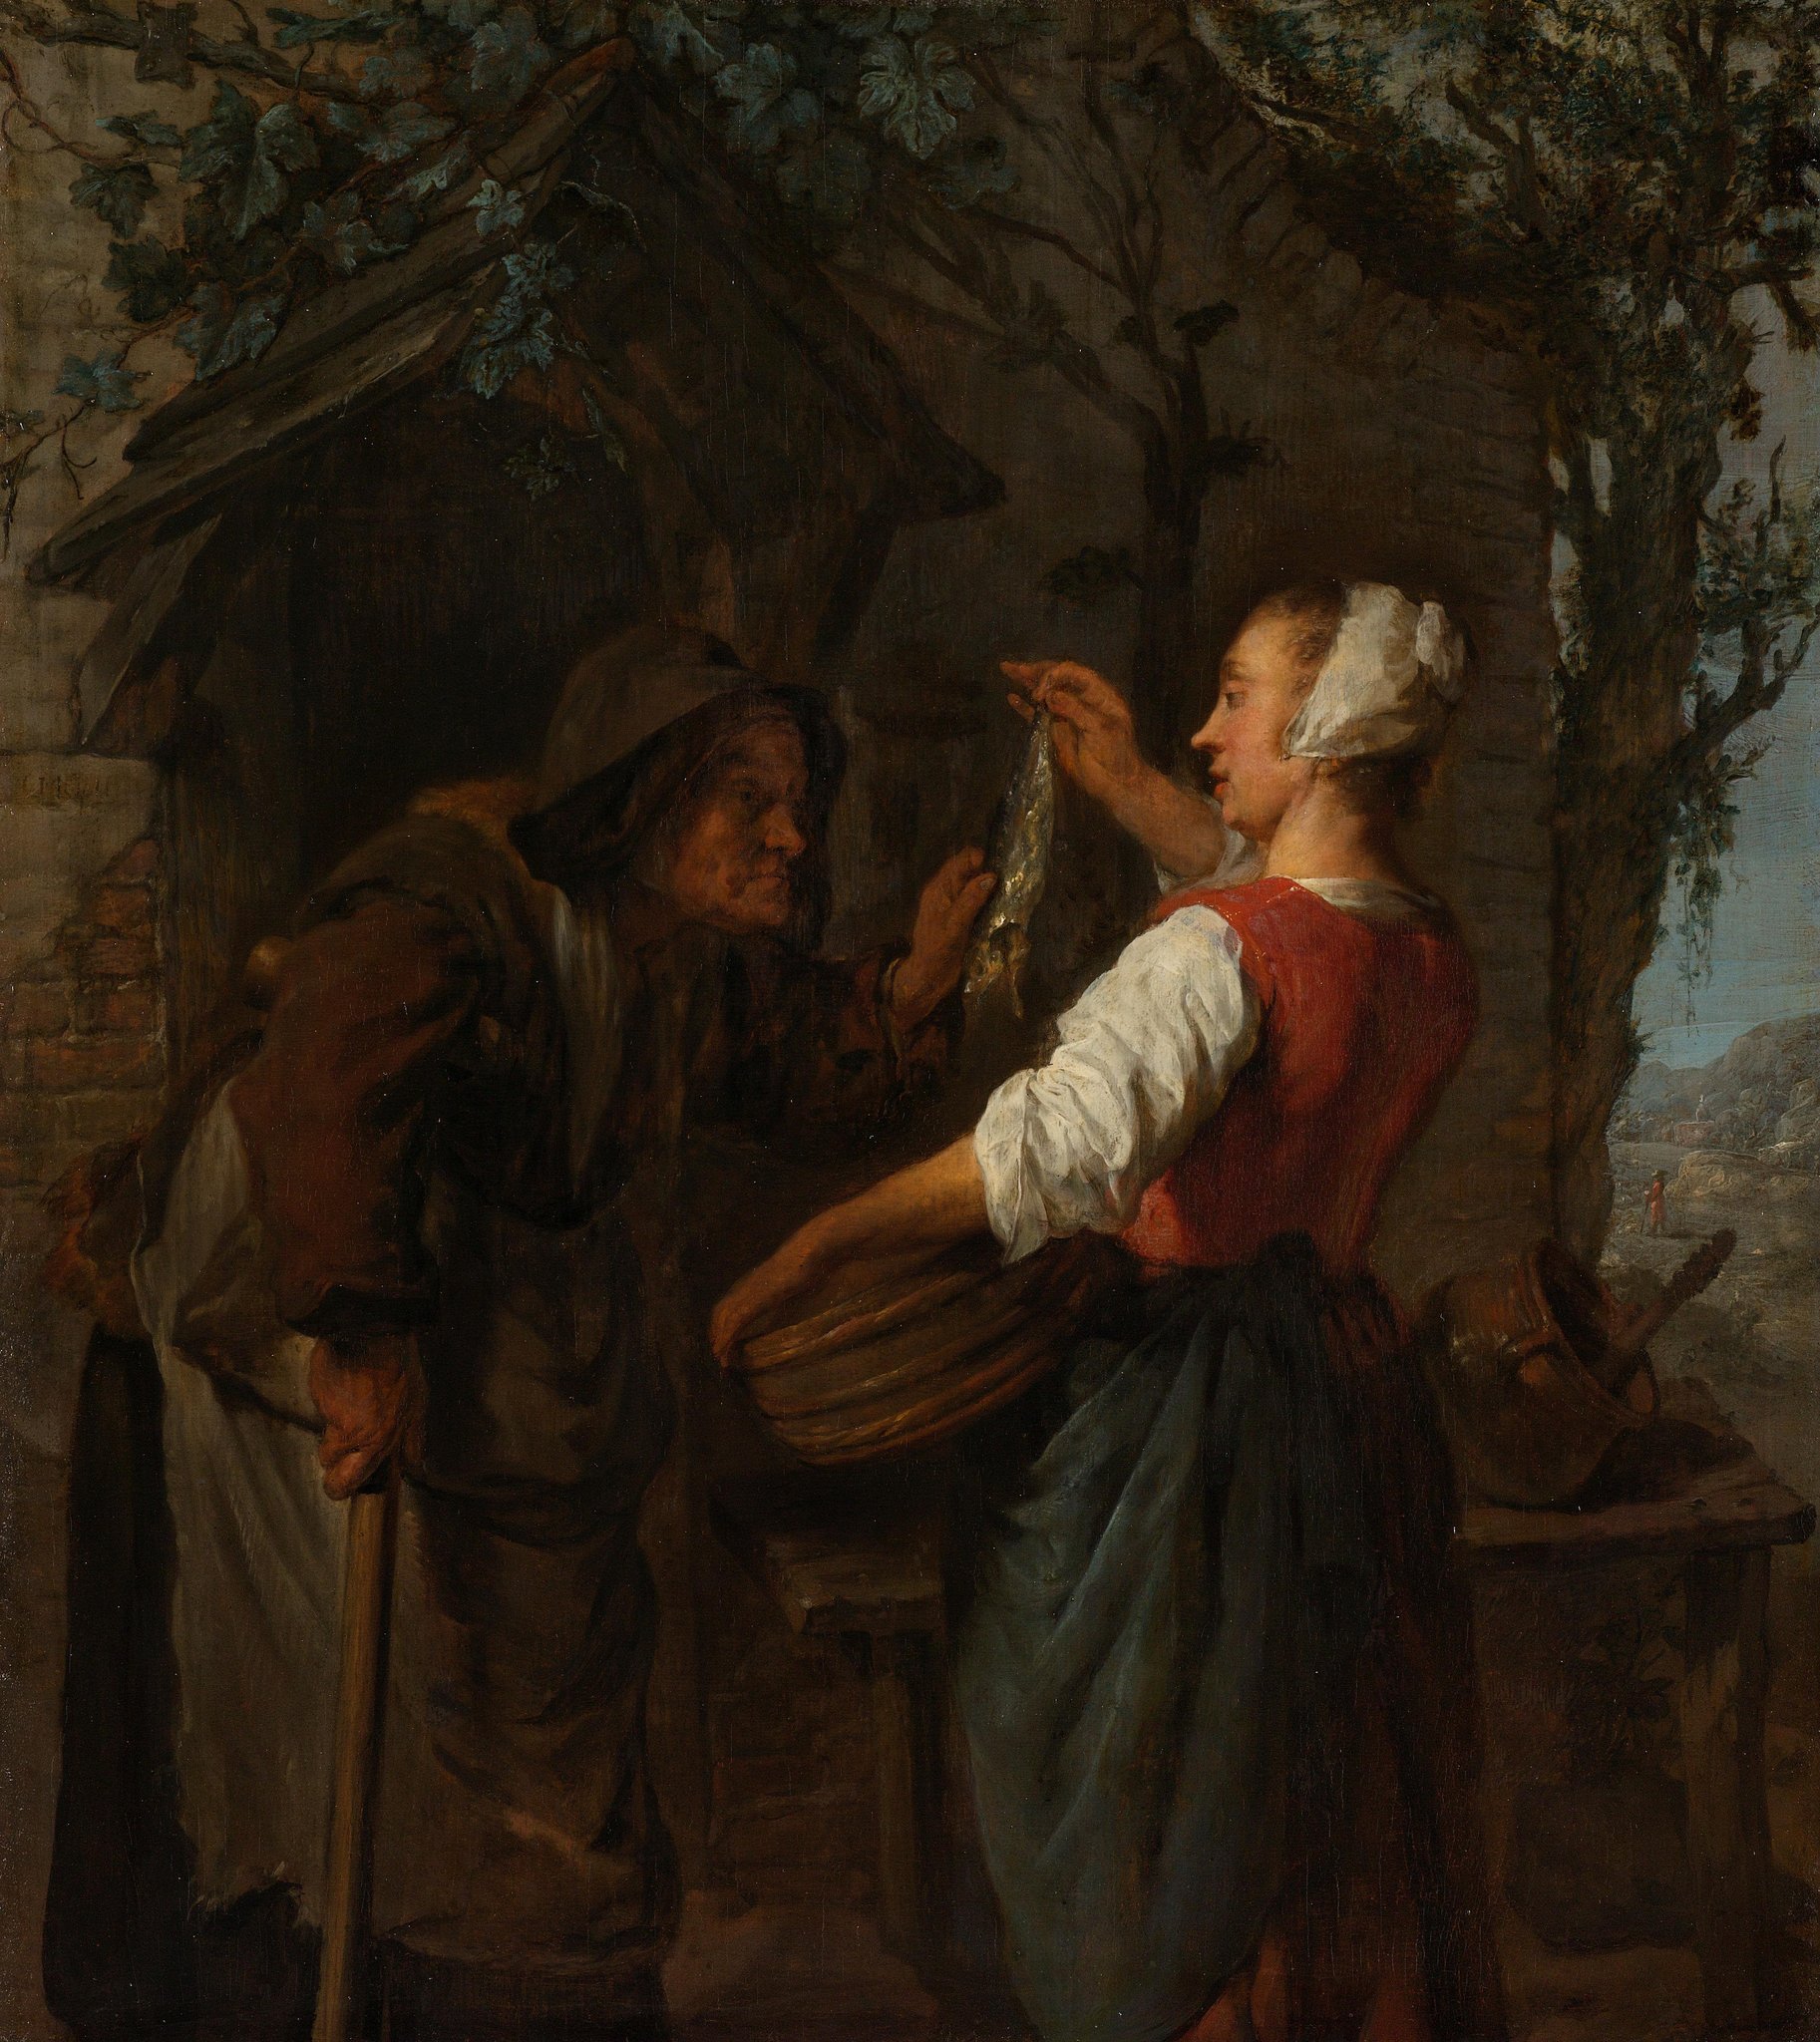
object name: painting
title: The Herring Seller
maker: gabriël metsu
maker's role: draughtsman, painter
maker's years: 1629-1667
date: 1661-1662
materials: oil, panel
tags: bony fishes: herring, street-trader - bb - women engaged in trade and commerce, selling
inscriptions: signature: ‘GMetsu’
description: With a critical eye, the woman in this painting inspects the herring being offered to her by a herring merchant. Unlike what is common today in the Netherlands, fish was primarily consumed in the morning and afternoon during the 17th century. Additionally, there was an abundant supply of fresh fish on Catholic fasting days such as Fridays, when meat was not eaten.